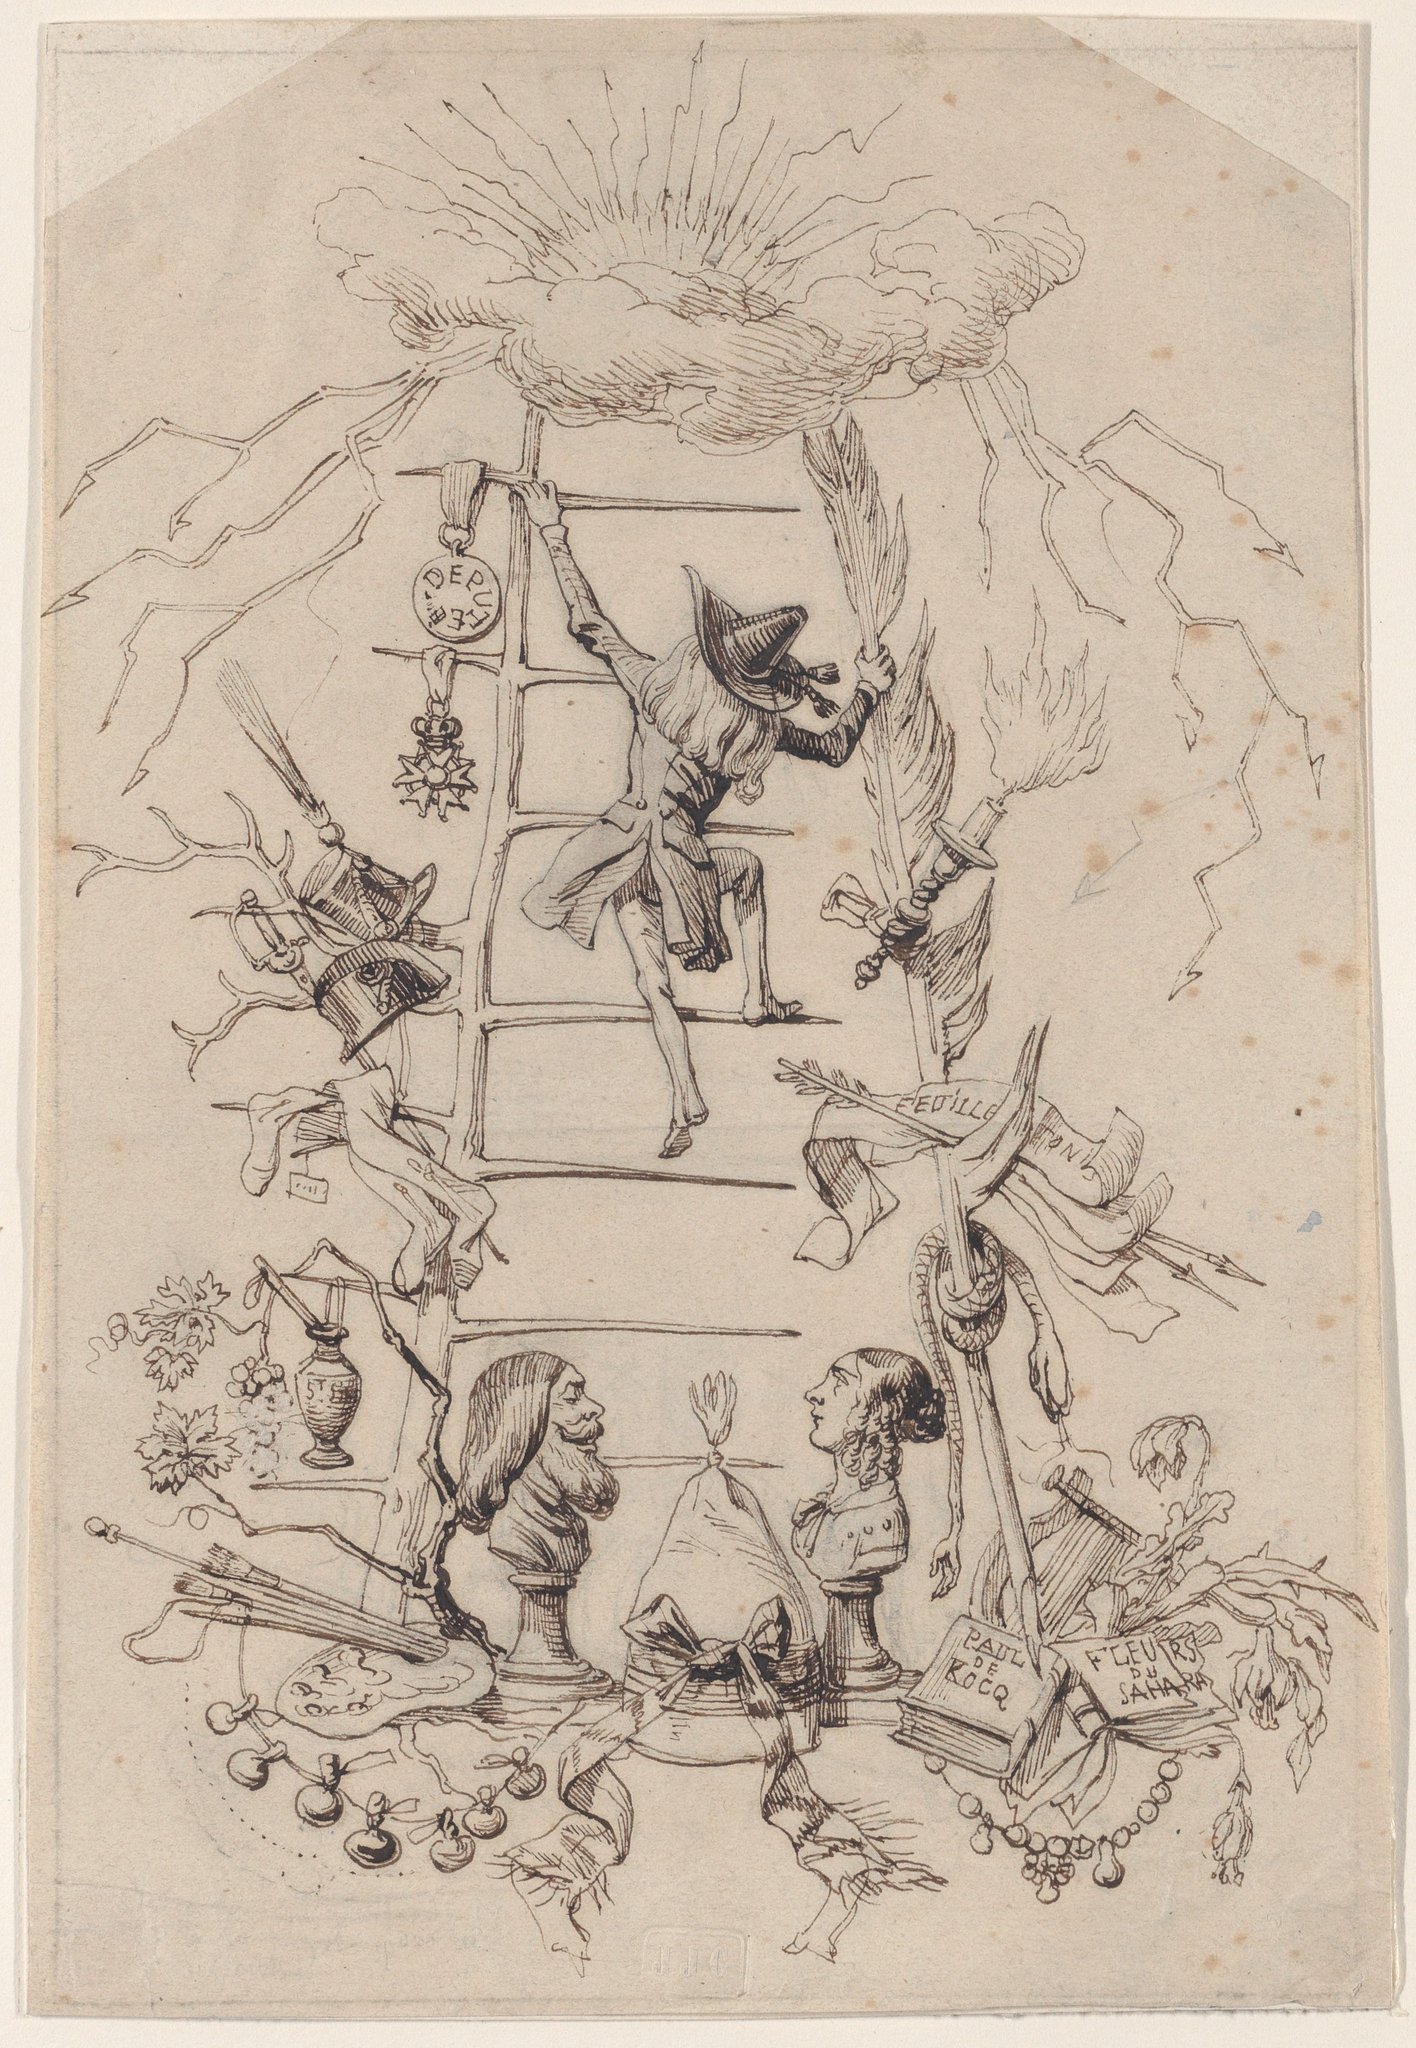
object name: drawing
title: Illustration in Jérôme Paturot, by Louis Reybaud, Paris, 1846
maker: j. j. grandville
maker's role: artist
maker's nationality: french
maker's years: 1803-1847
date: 1846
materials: ink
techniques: pen